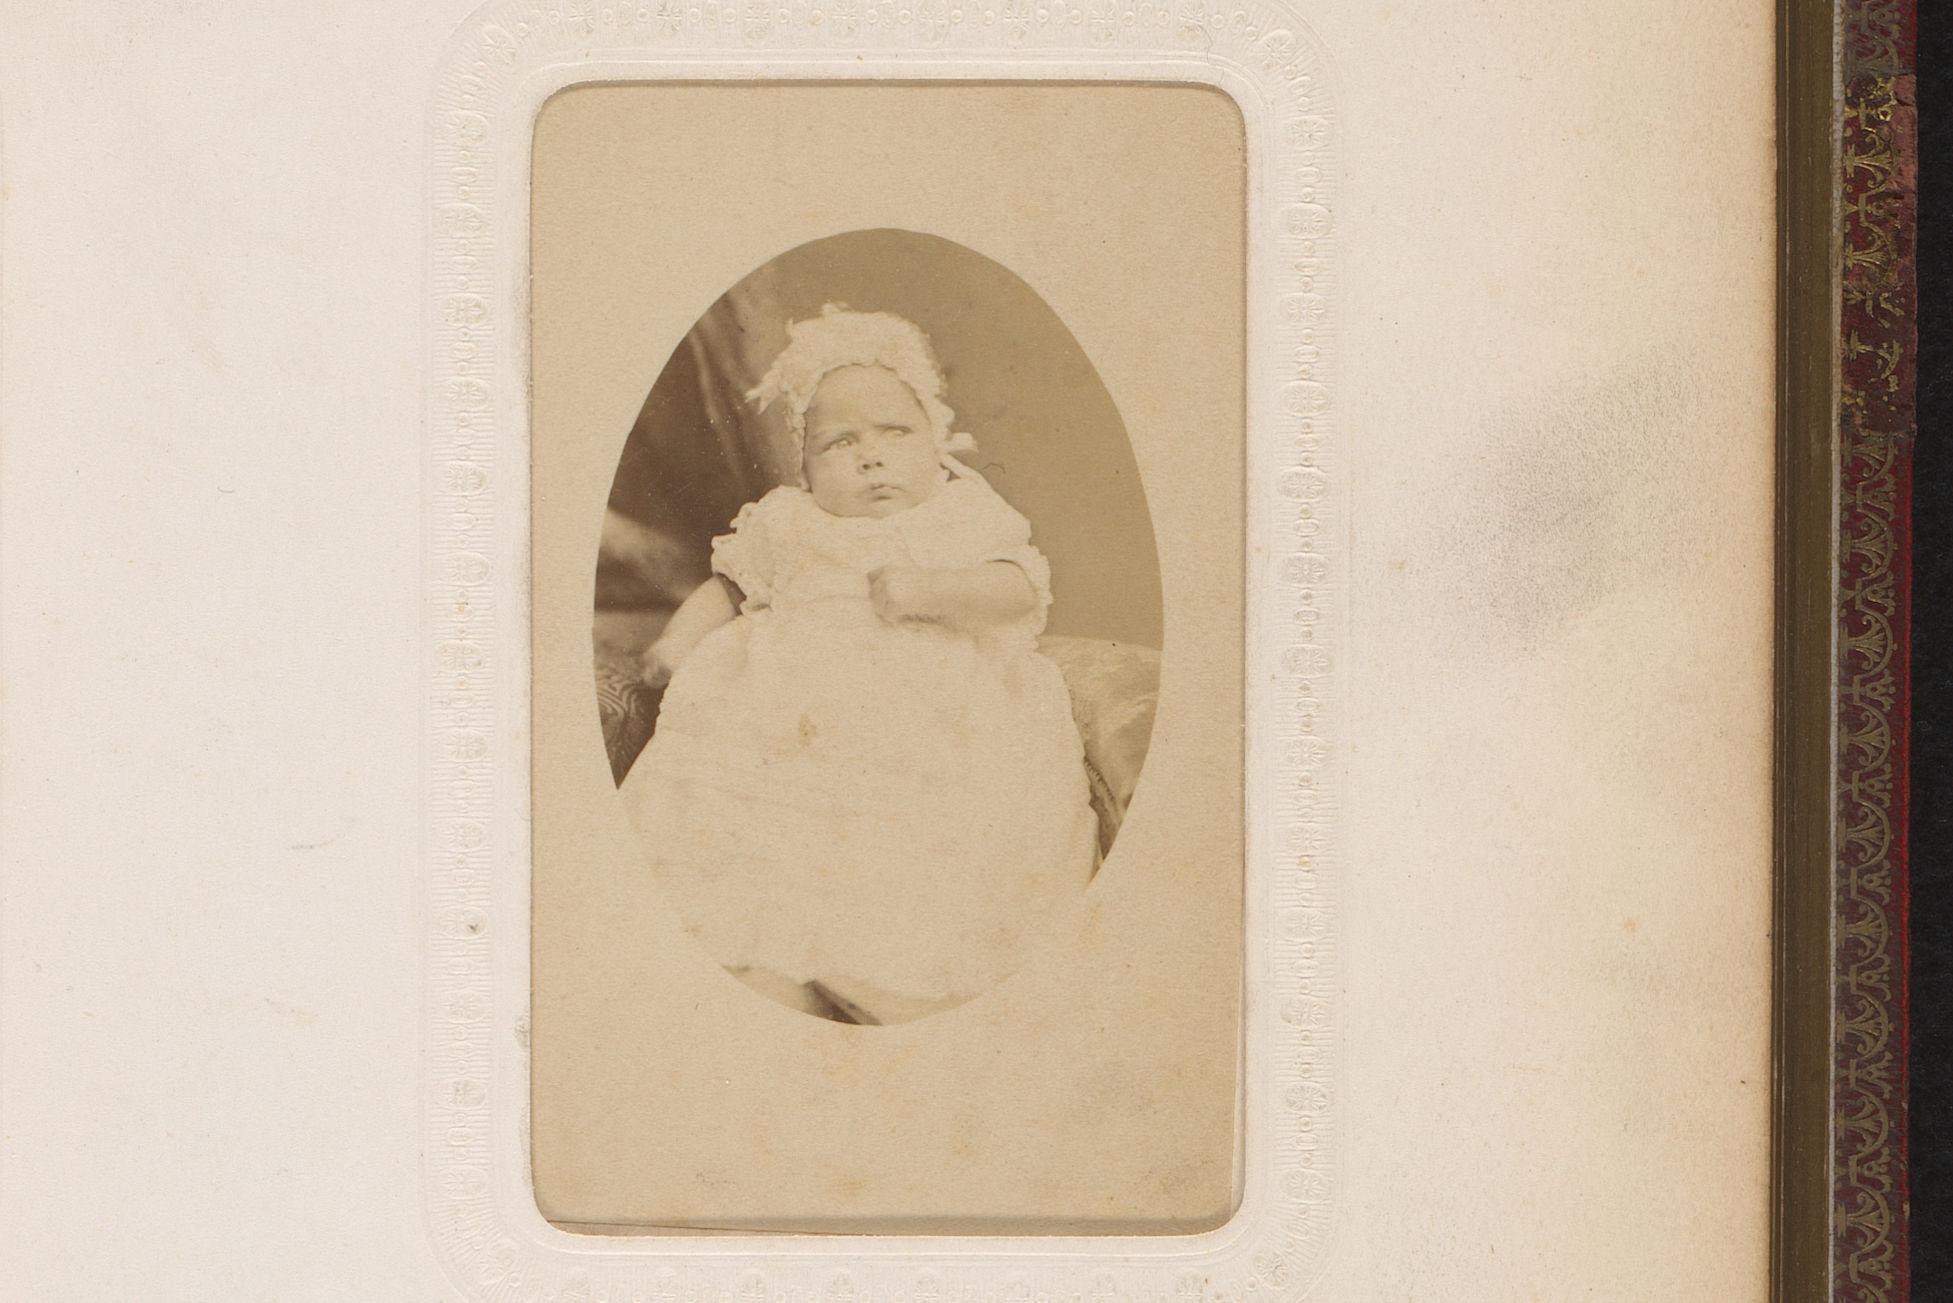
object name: photograph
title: Portret van een meisje in witte jurk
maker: Anonymous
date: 1880-1920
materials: cardboard, photographic support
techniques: collodion silver print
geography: netherlands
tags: historical persons - bb - woman, toddler (female), dress, gown